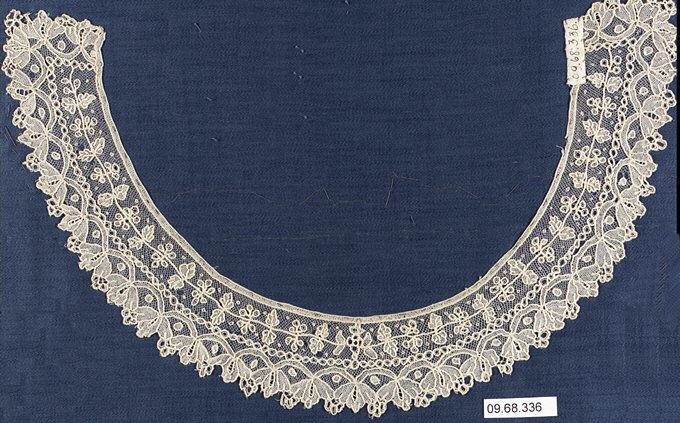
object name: collar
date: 1801-1900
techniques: lace